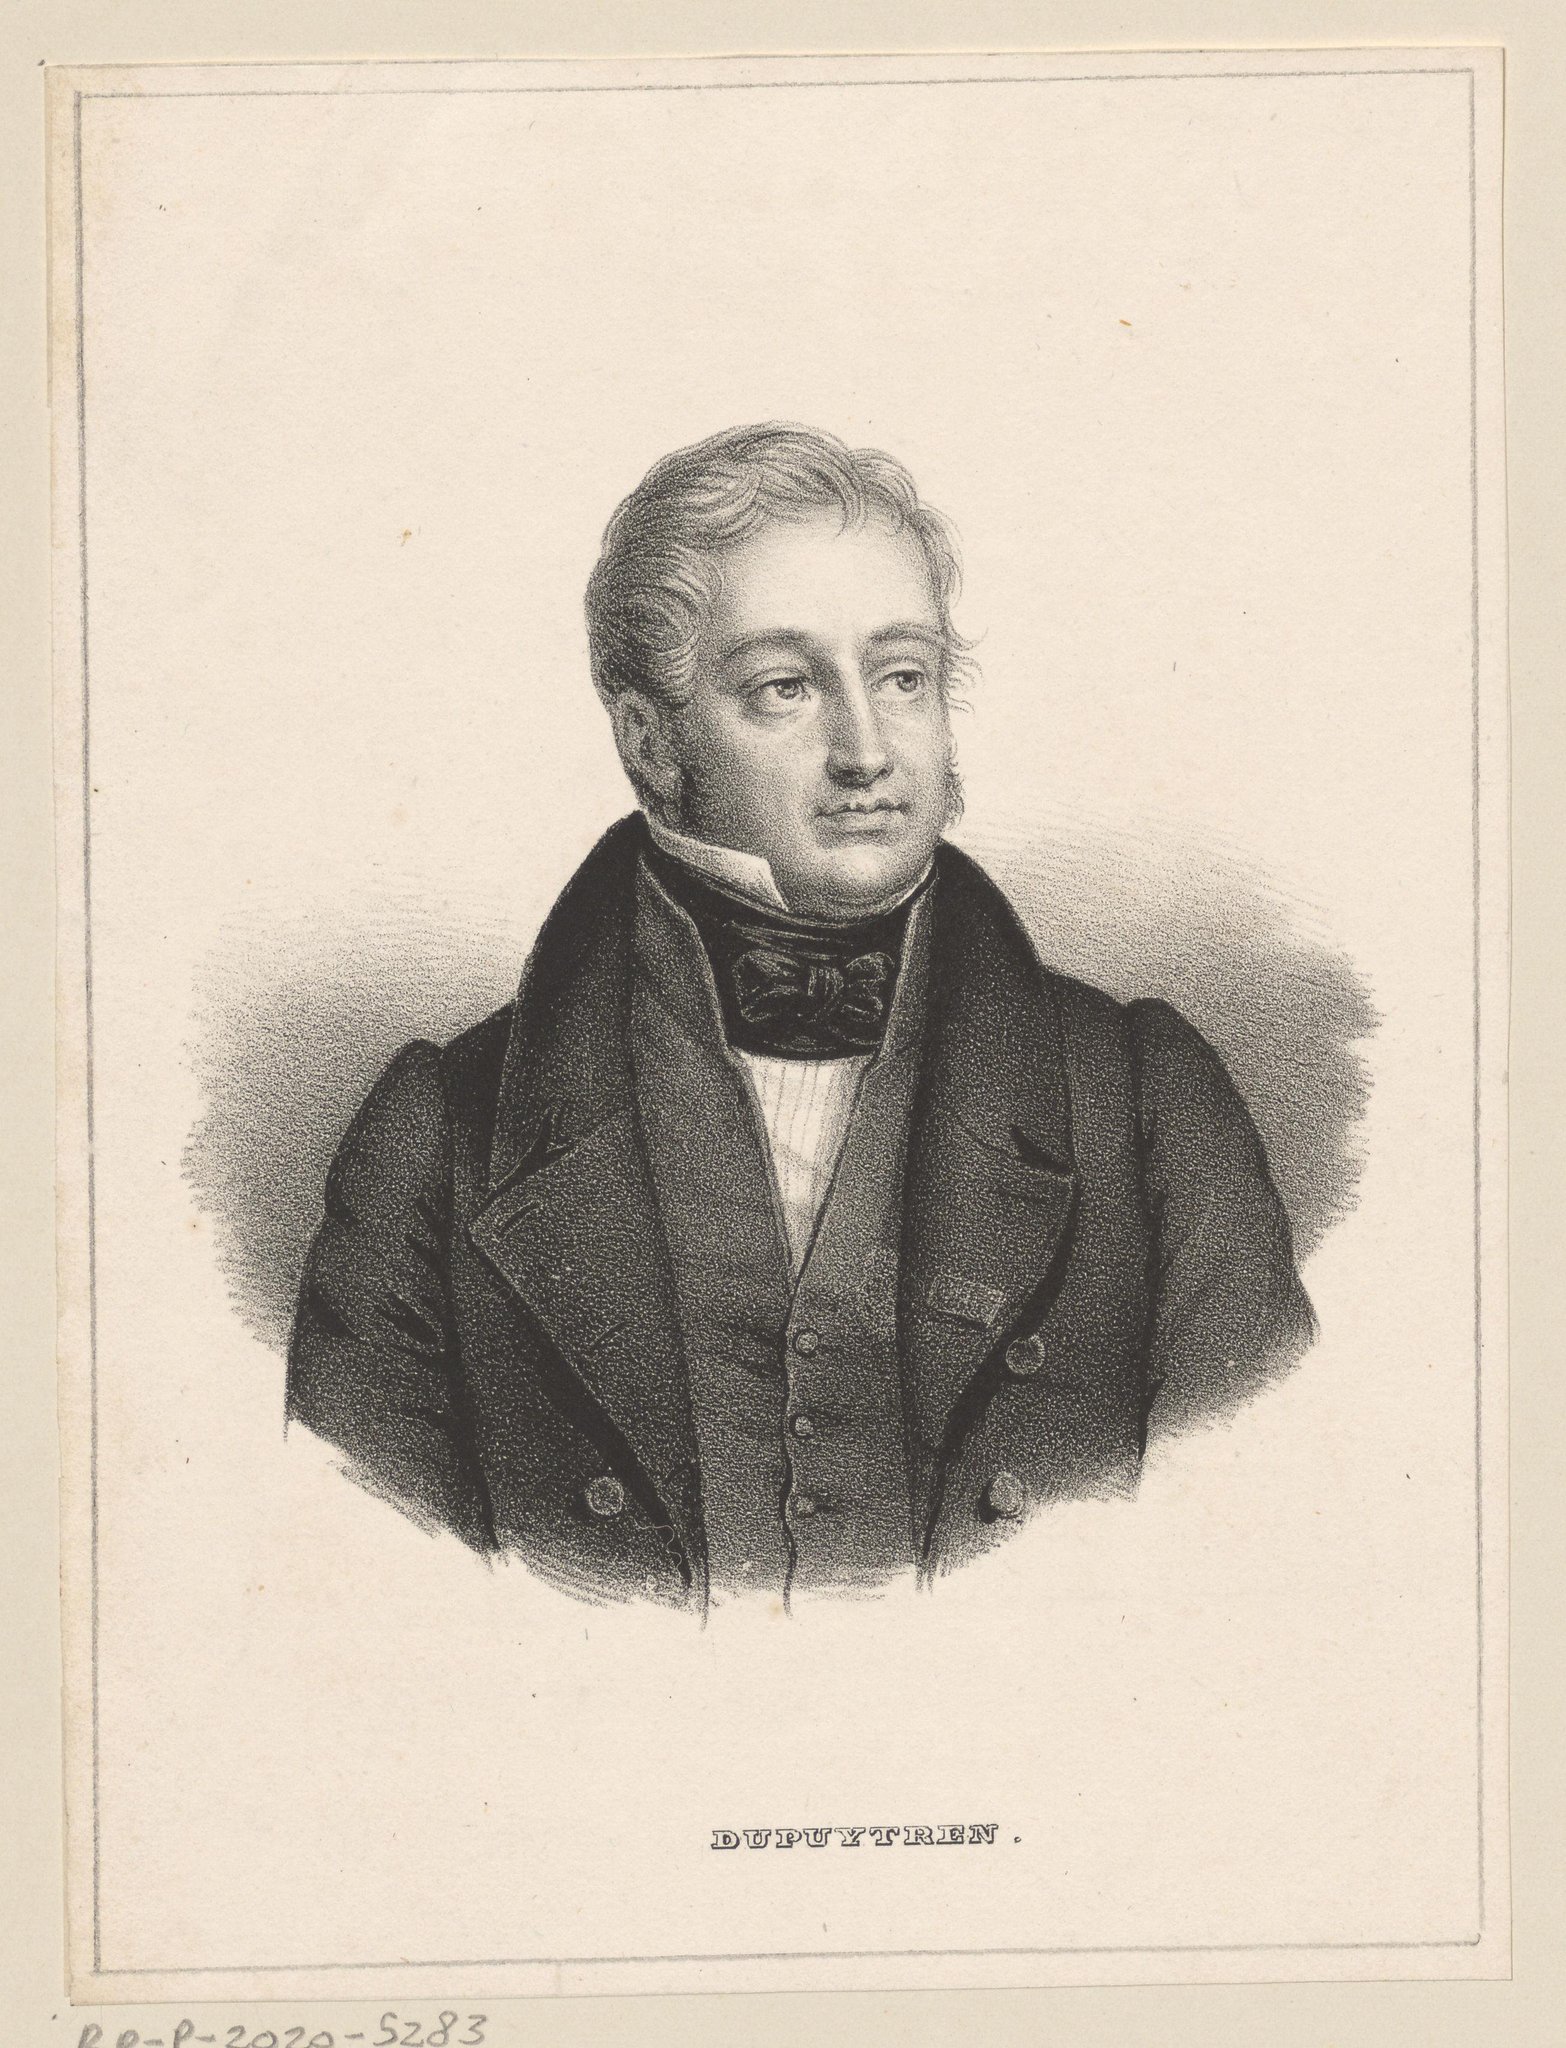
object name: print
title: Portret van Guillaume Dupuytren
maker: Anonymous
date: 1815-1850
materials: paper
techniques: lithograph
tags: historical persons, barber; surgeon